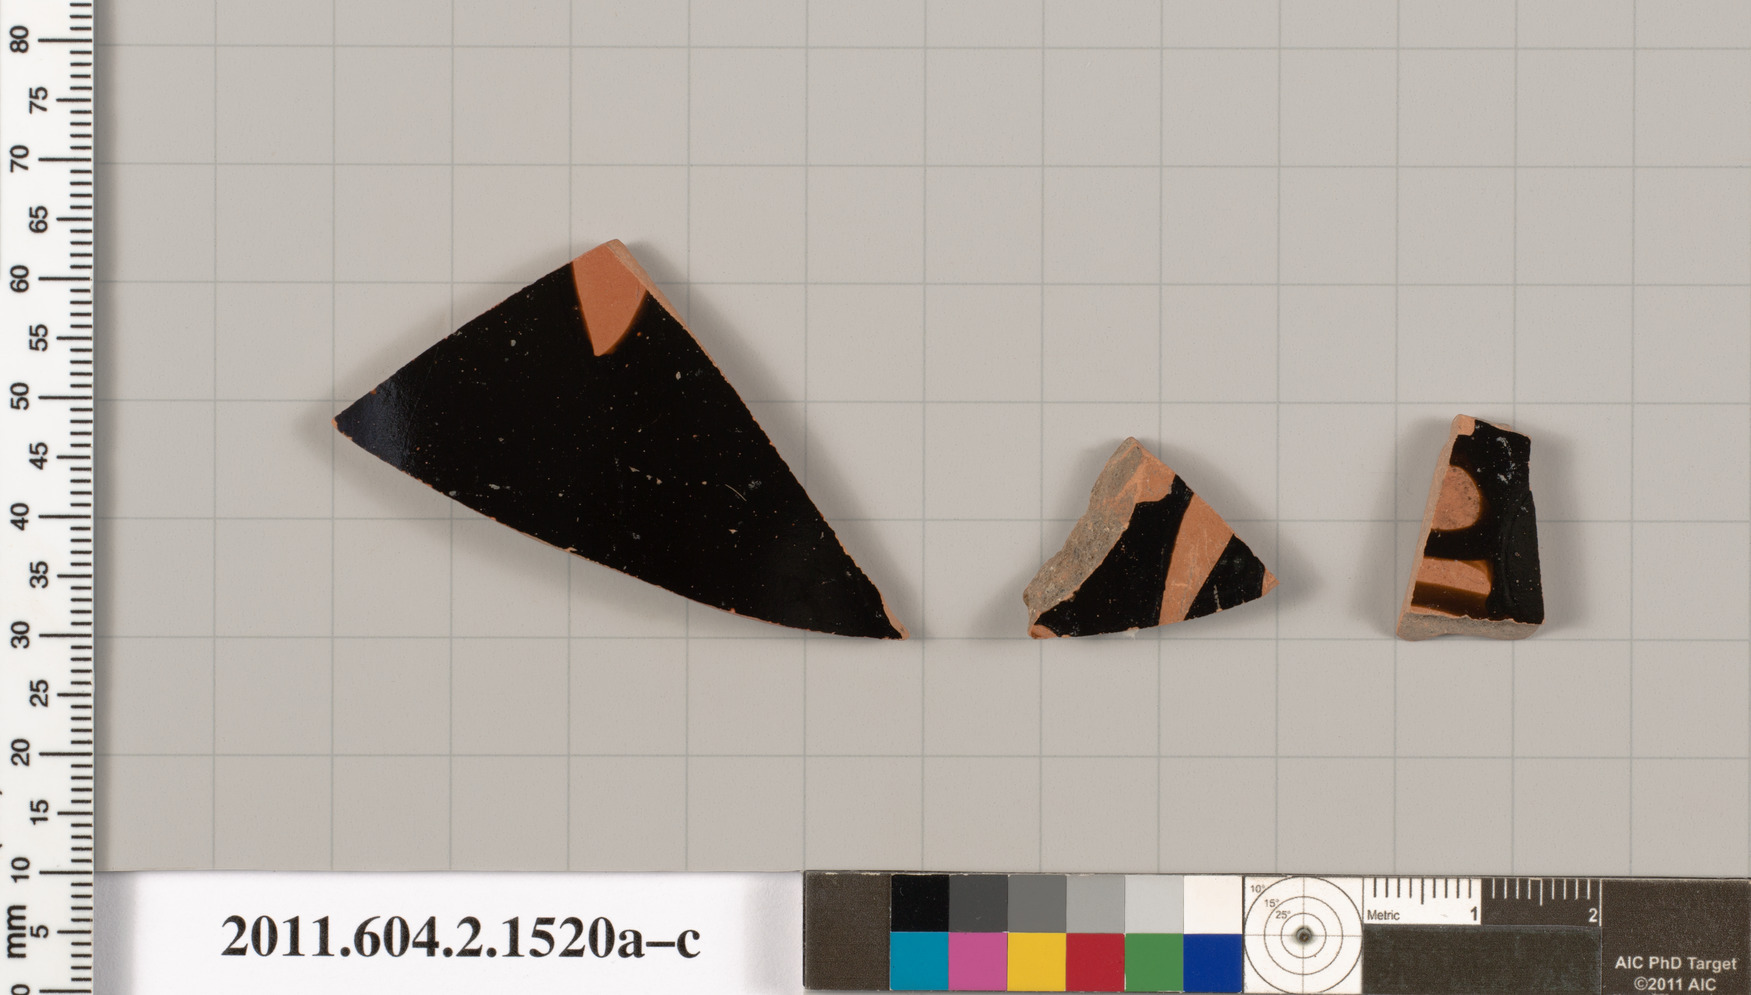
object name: skyphos fragment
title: Terracotta fragments of skyphoi (deep drinking cups)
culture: greek, attic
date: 450-401 BCE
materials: terracotta